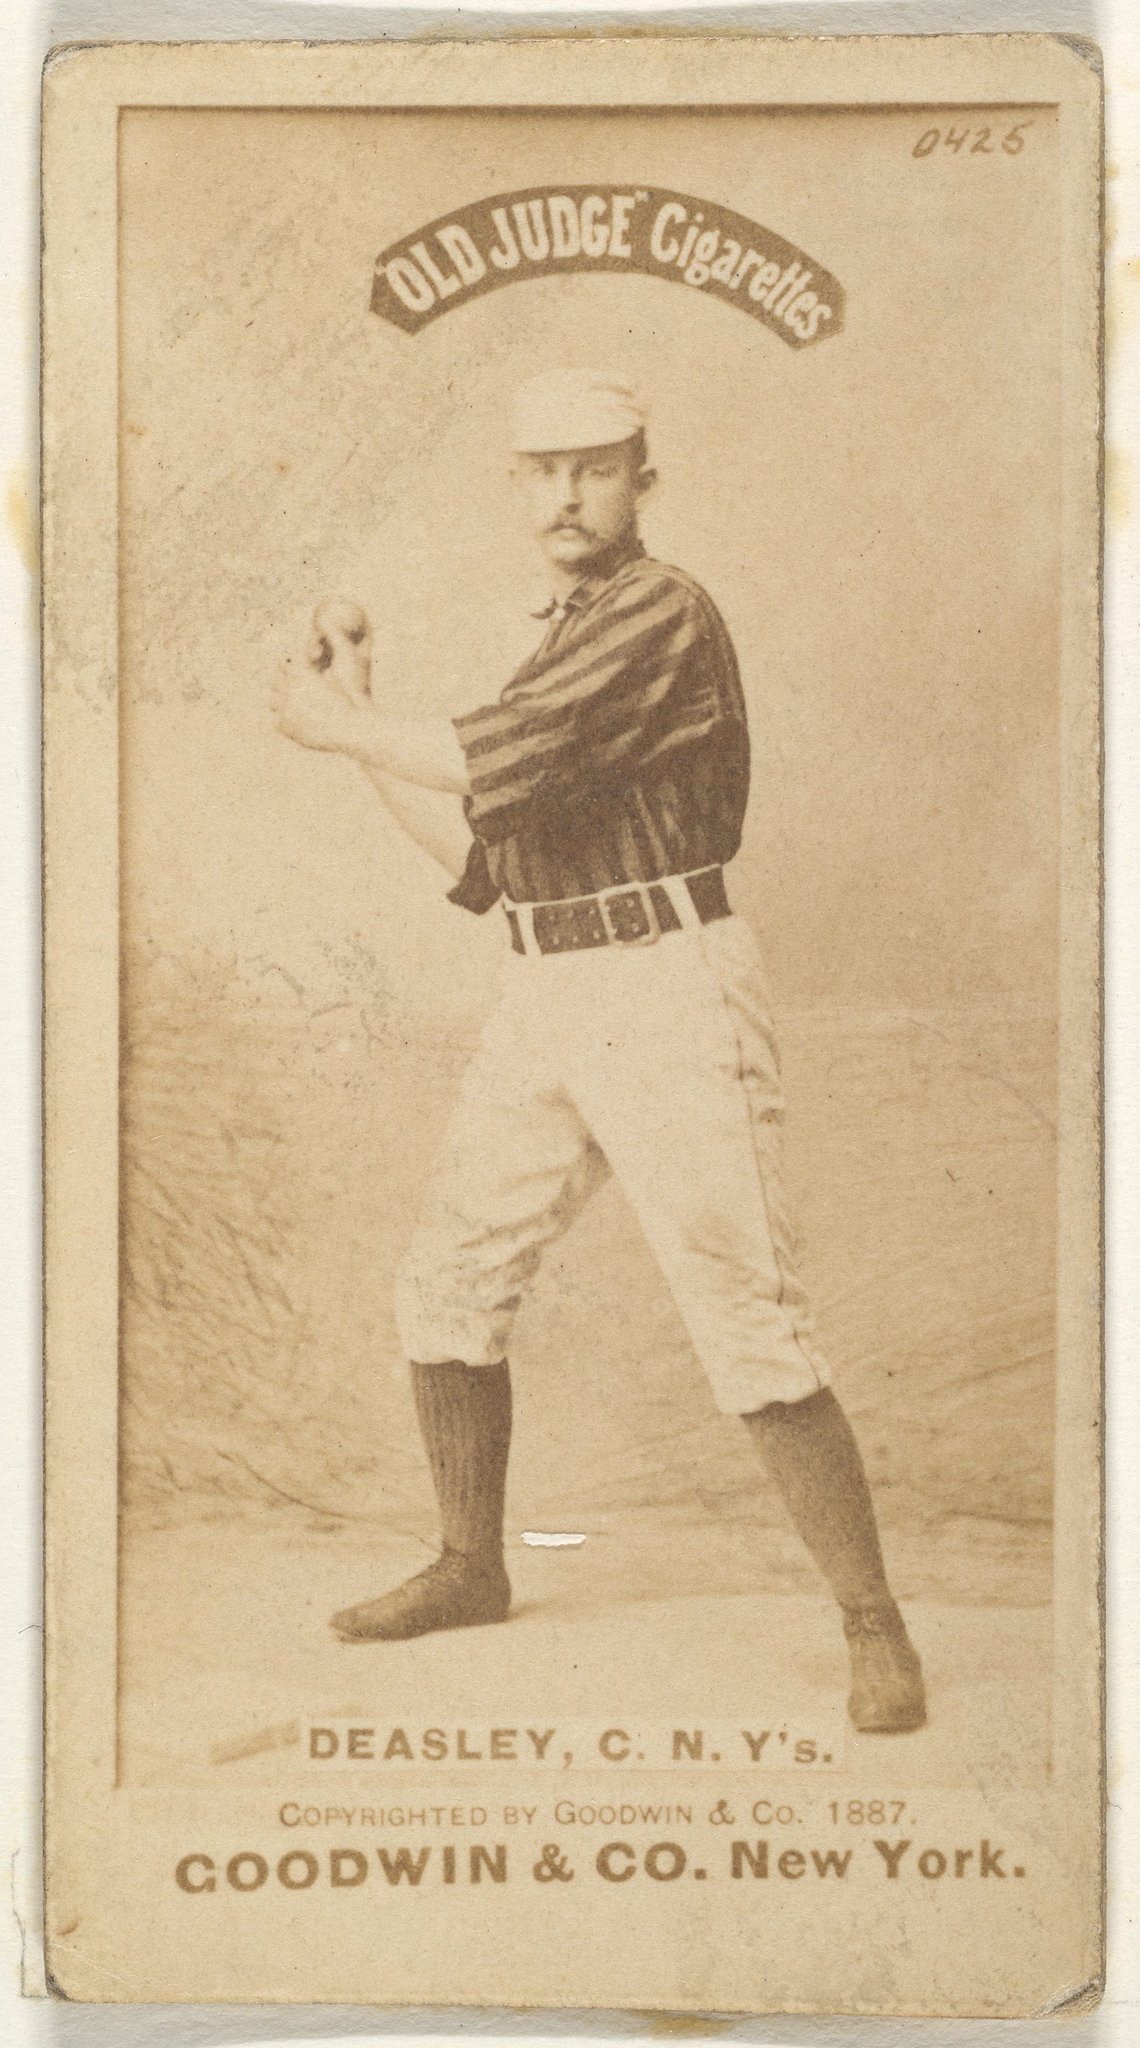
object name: baseball card, photograph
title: Thomas H. "Pat" Deasley, Catcher, New York, from the Old Judge series (N172) for Old Judge Cigarettes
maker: goodwin & company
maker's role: publisher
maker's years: 1850-1950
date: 1887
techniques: albumen silver print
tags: men,portraits,baseball,athletes